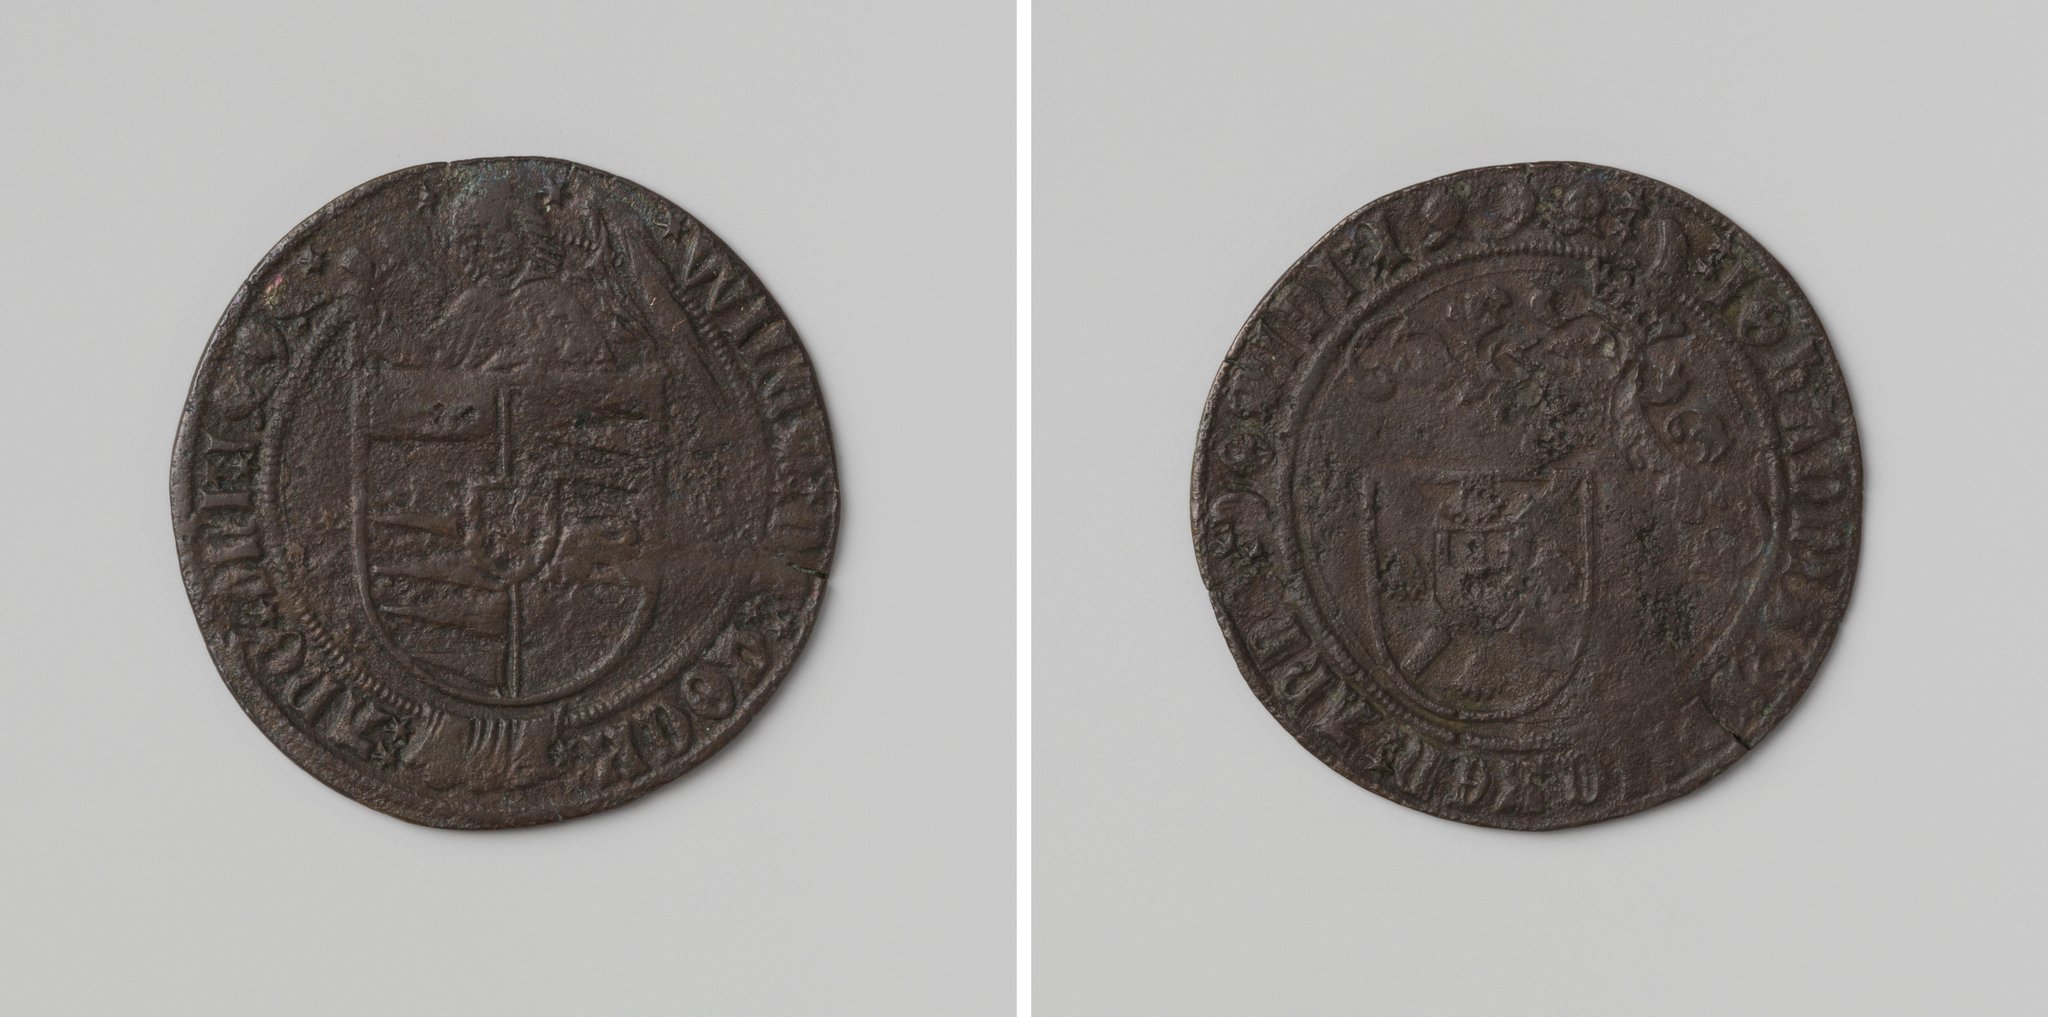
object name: jeton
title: Willem de Cock en Johannes Spicker, burgemeesters van Brussel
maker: Anonymous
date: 1494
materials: copper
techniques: striking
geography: brussels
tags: brussels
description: Koperen penning. Voorzijde: door engel gedragen wapenschild binnen omschrift. Keerzijde: gehelmd wapenschild binnen omschrift.